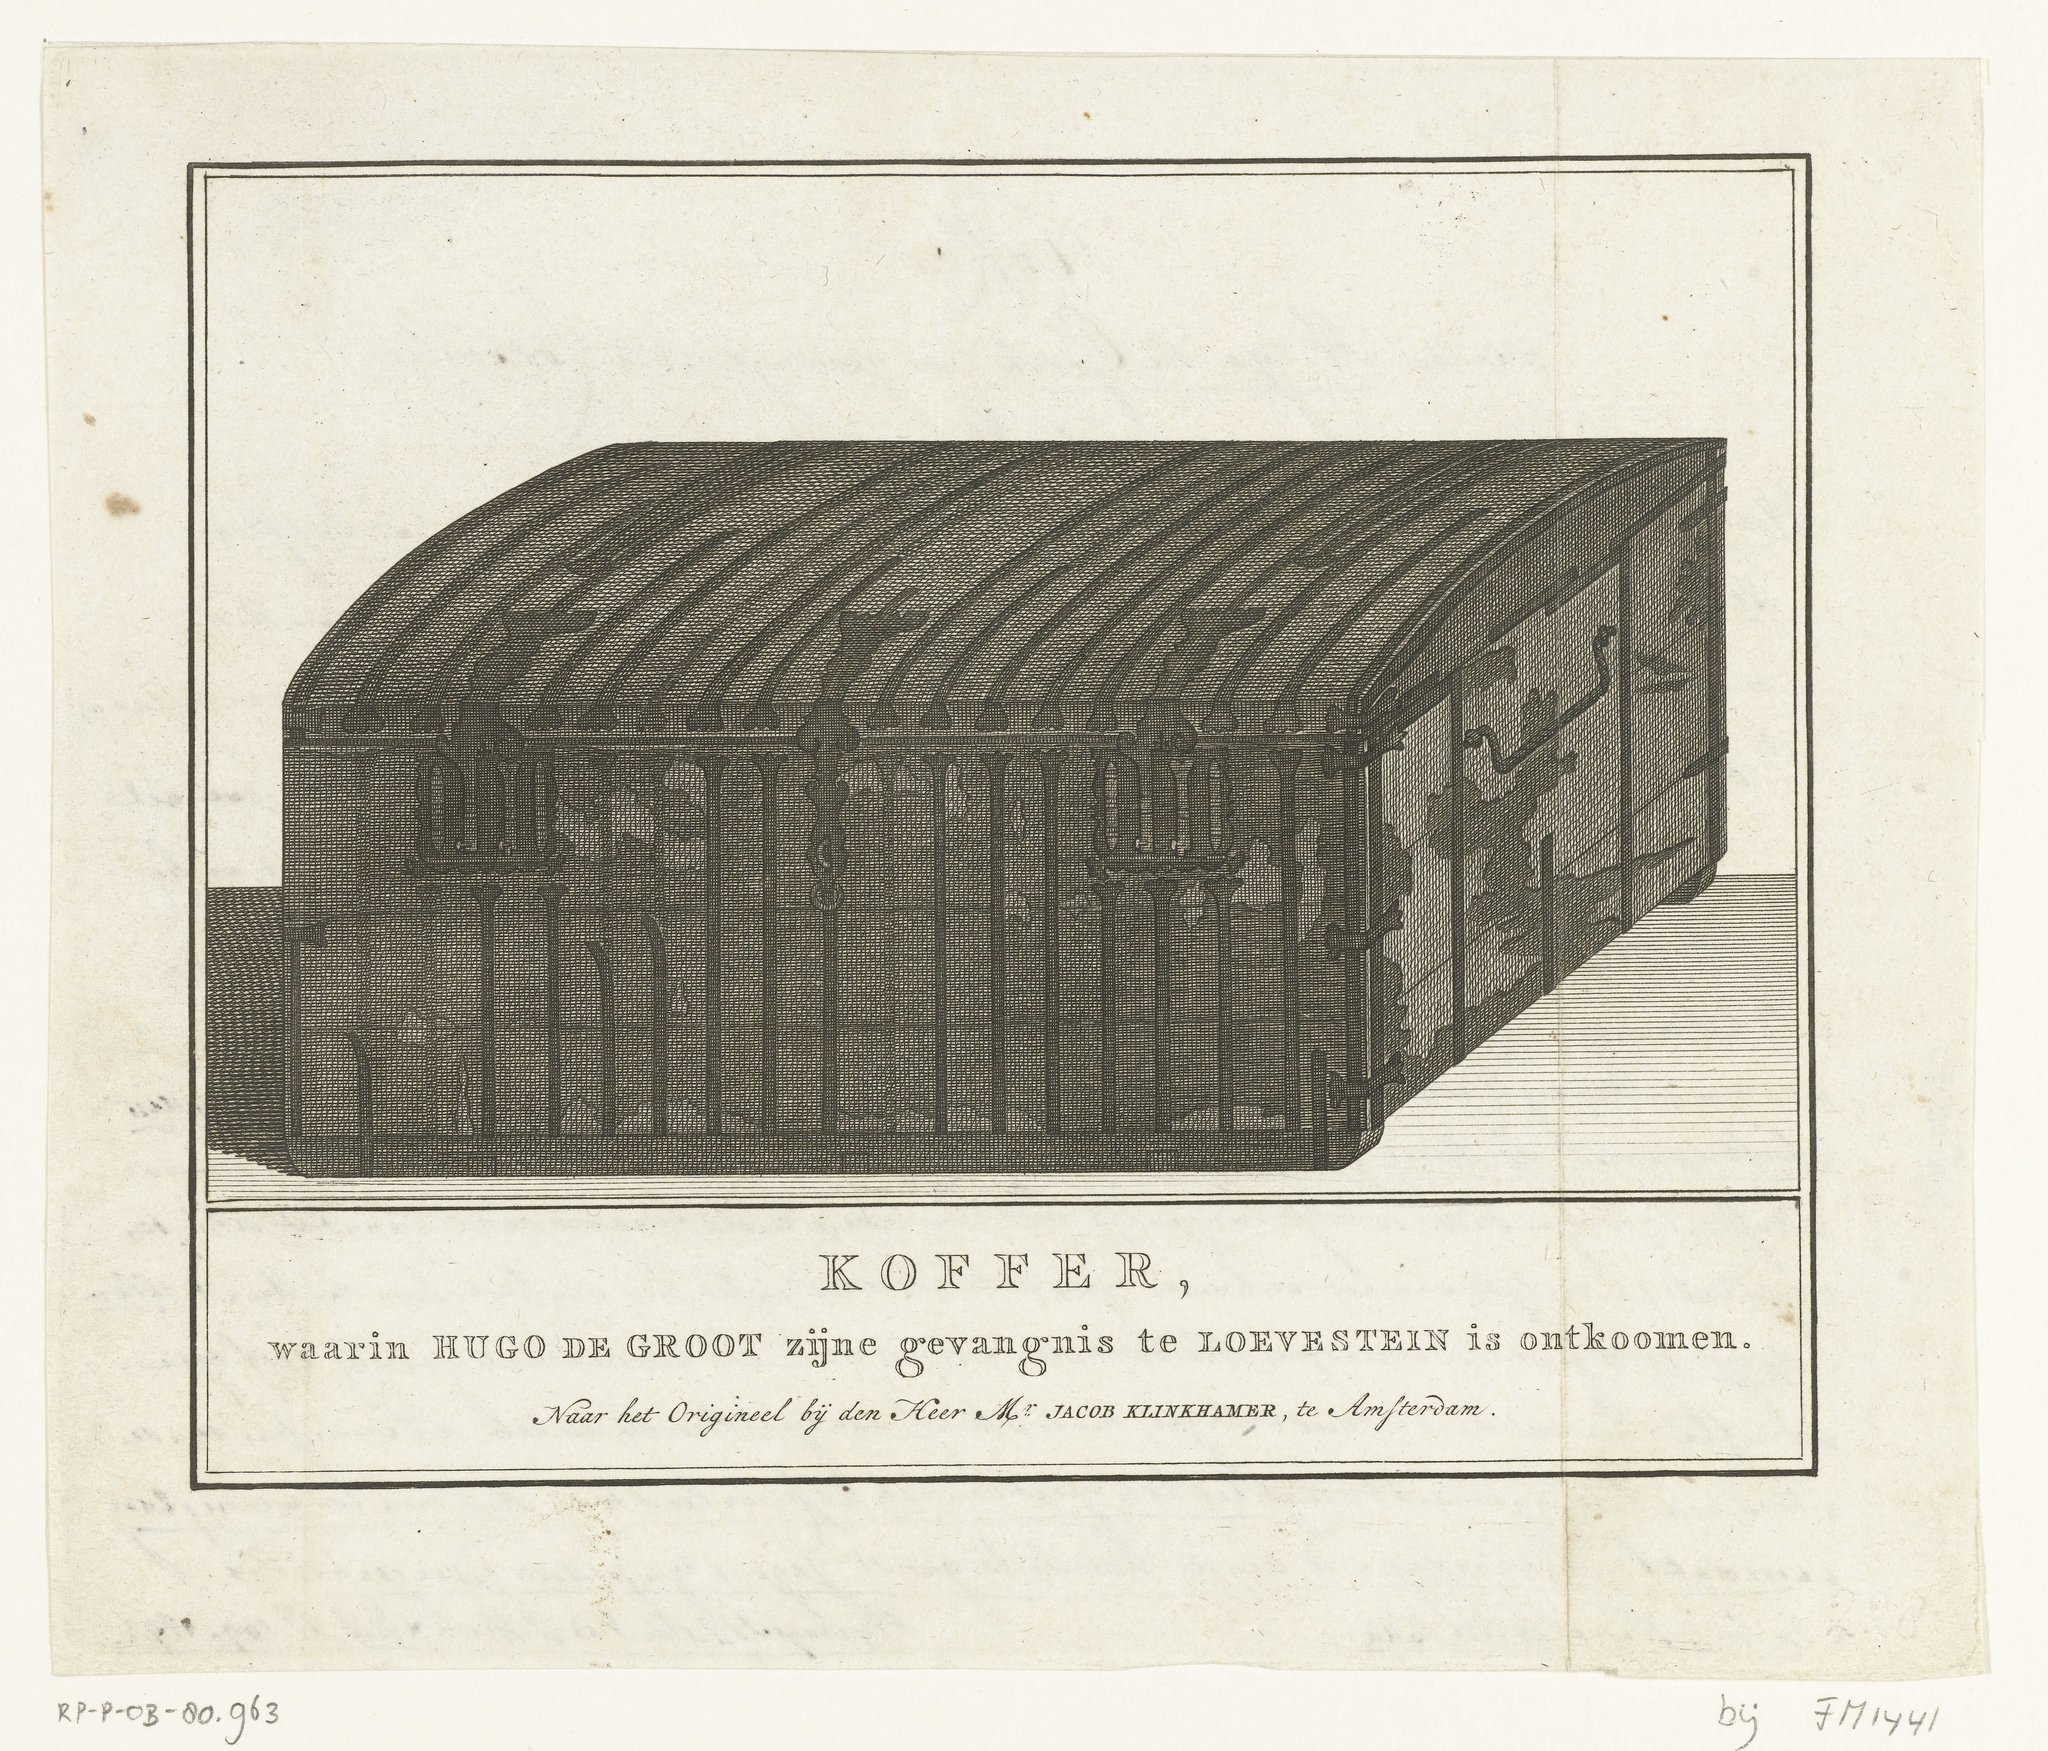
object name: historical object representation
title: Koffer, waarin Hugo de Groot zijne gevangnis te Loevestein is ontkoomen. Naar het Origineel bij den Heer Mr. Jacob Klinkhamer, te Amsterdam.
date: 1783-1784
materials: paper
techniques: etching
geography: netherlands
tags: delft, hugo de groot, trunk, suit-case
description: De boekenkist waarin Hugo de Groot uit Slot Loevestein ontsnapt is op 22 maart 1621. Afbeelding van de kist met gesloten deksel, in 1783 in het bezit van Mr. Jacob Klinkhamer te Amsterdam. Beschreven op de achterzijde met pen.